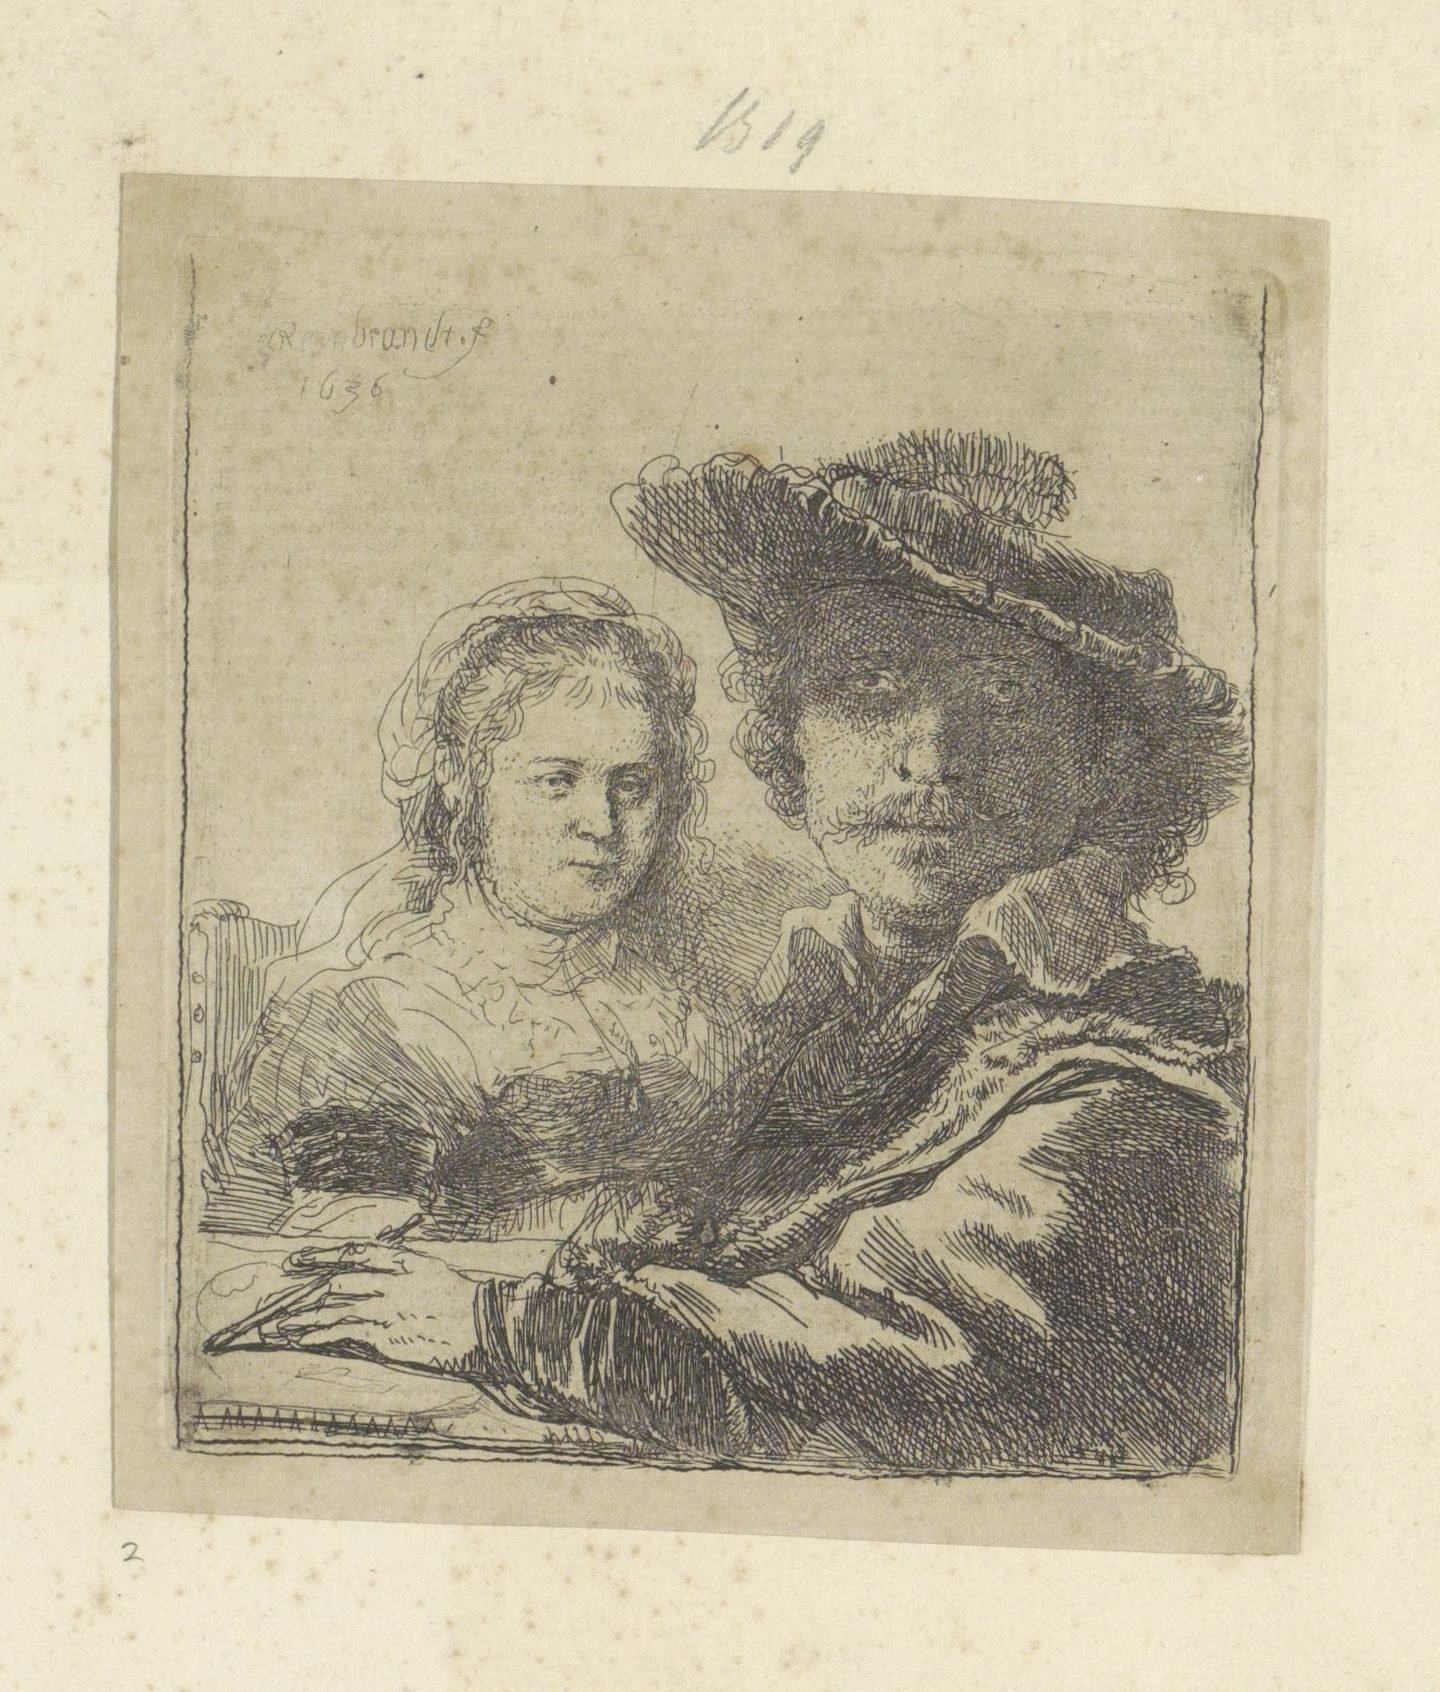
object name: album leaf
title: Recueil de quatre-vingt-cinq estampes originales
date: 1636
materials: paper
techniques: etching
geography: paris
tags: leiden, amsterdam, painter, print maker, draughtsman, rembrandt van rijn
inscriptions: date